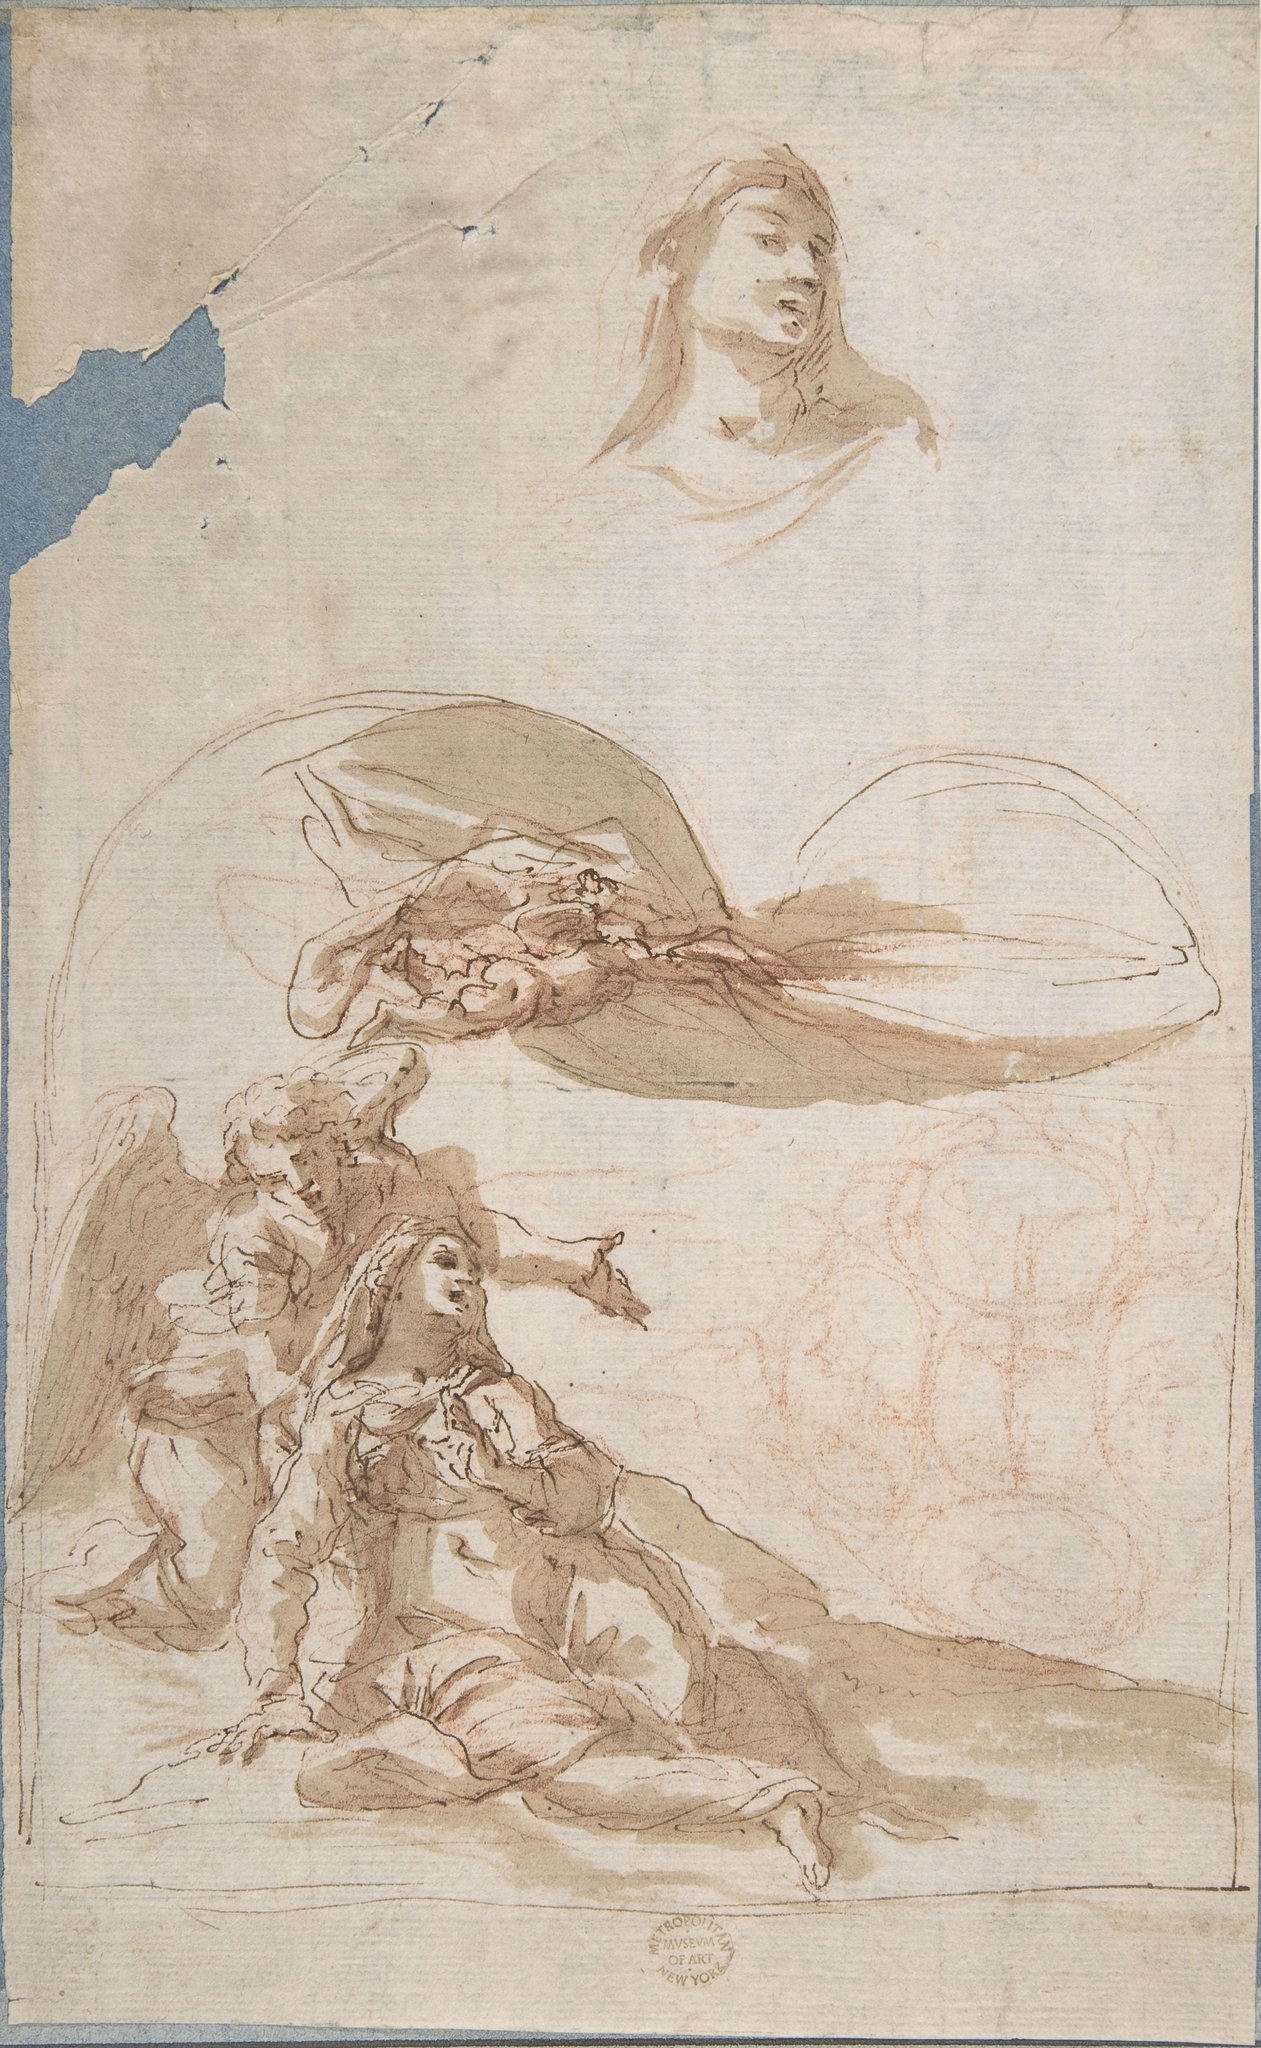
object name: drawing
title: Saint in Ecstasy; Study of Saint's Head (recto); Sketches of Putti (verso)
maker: anonymous, italian, roman-bolognese, 17th century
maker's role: artist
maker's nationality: italian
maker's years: 1600-1700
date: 1601-1700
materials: chalk, ink, paper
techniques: brush, pen, wash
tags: heads,women,putti,saints